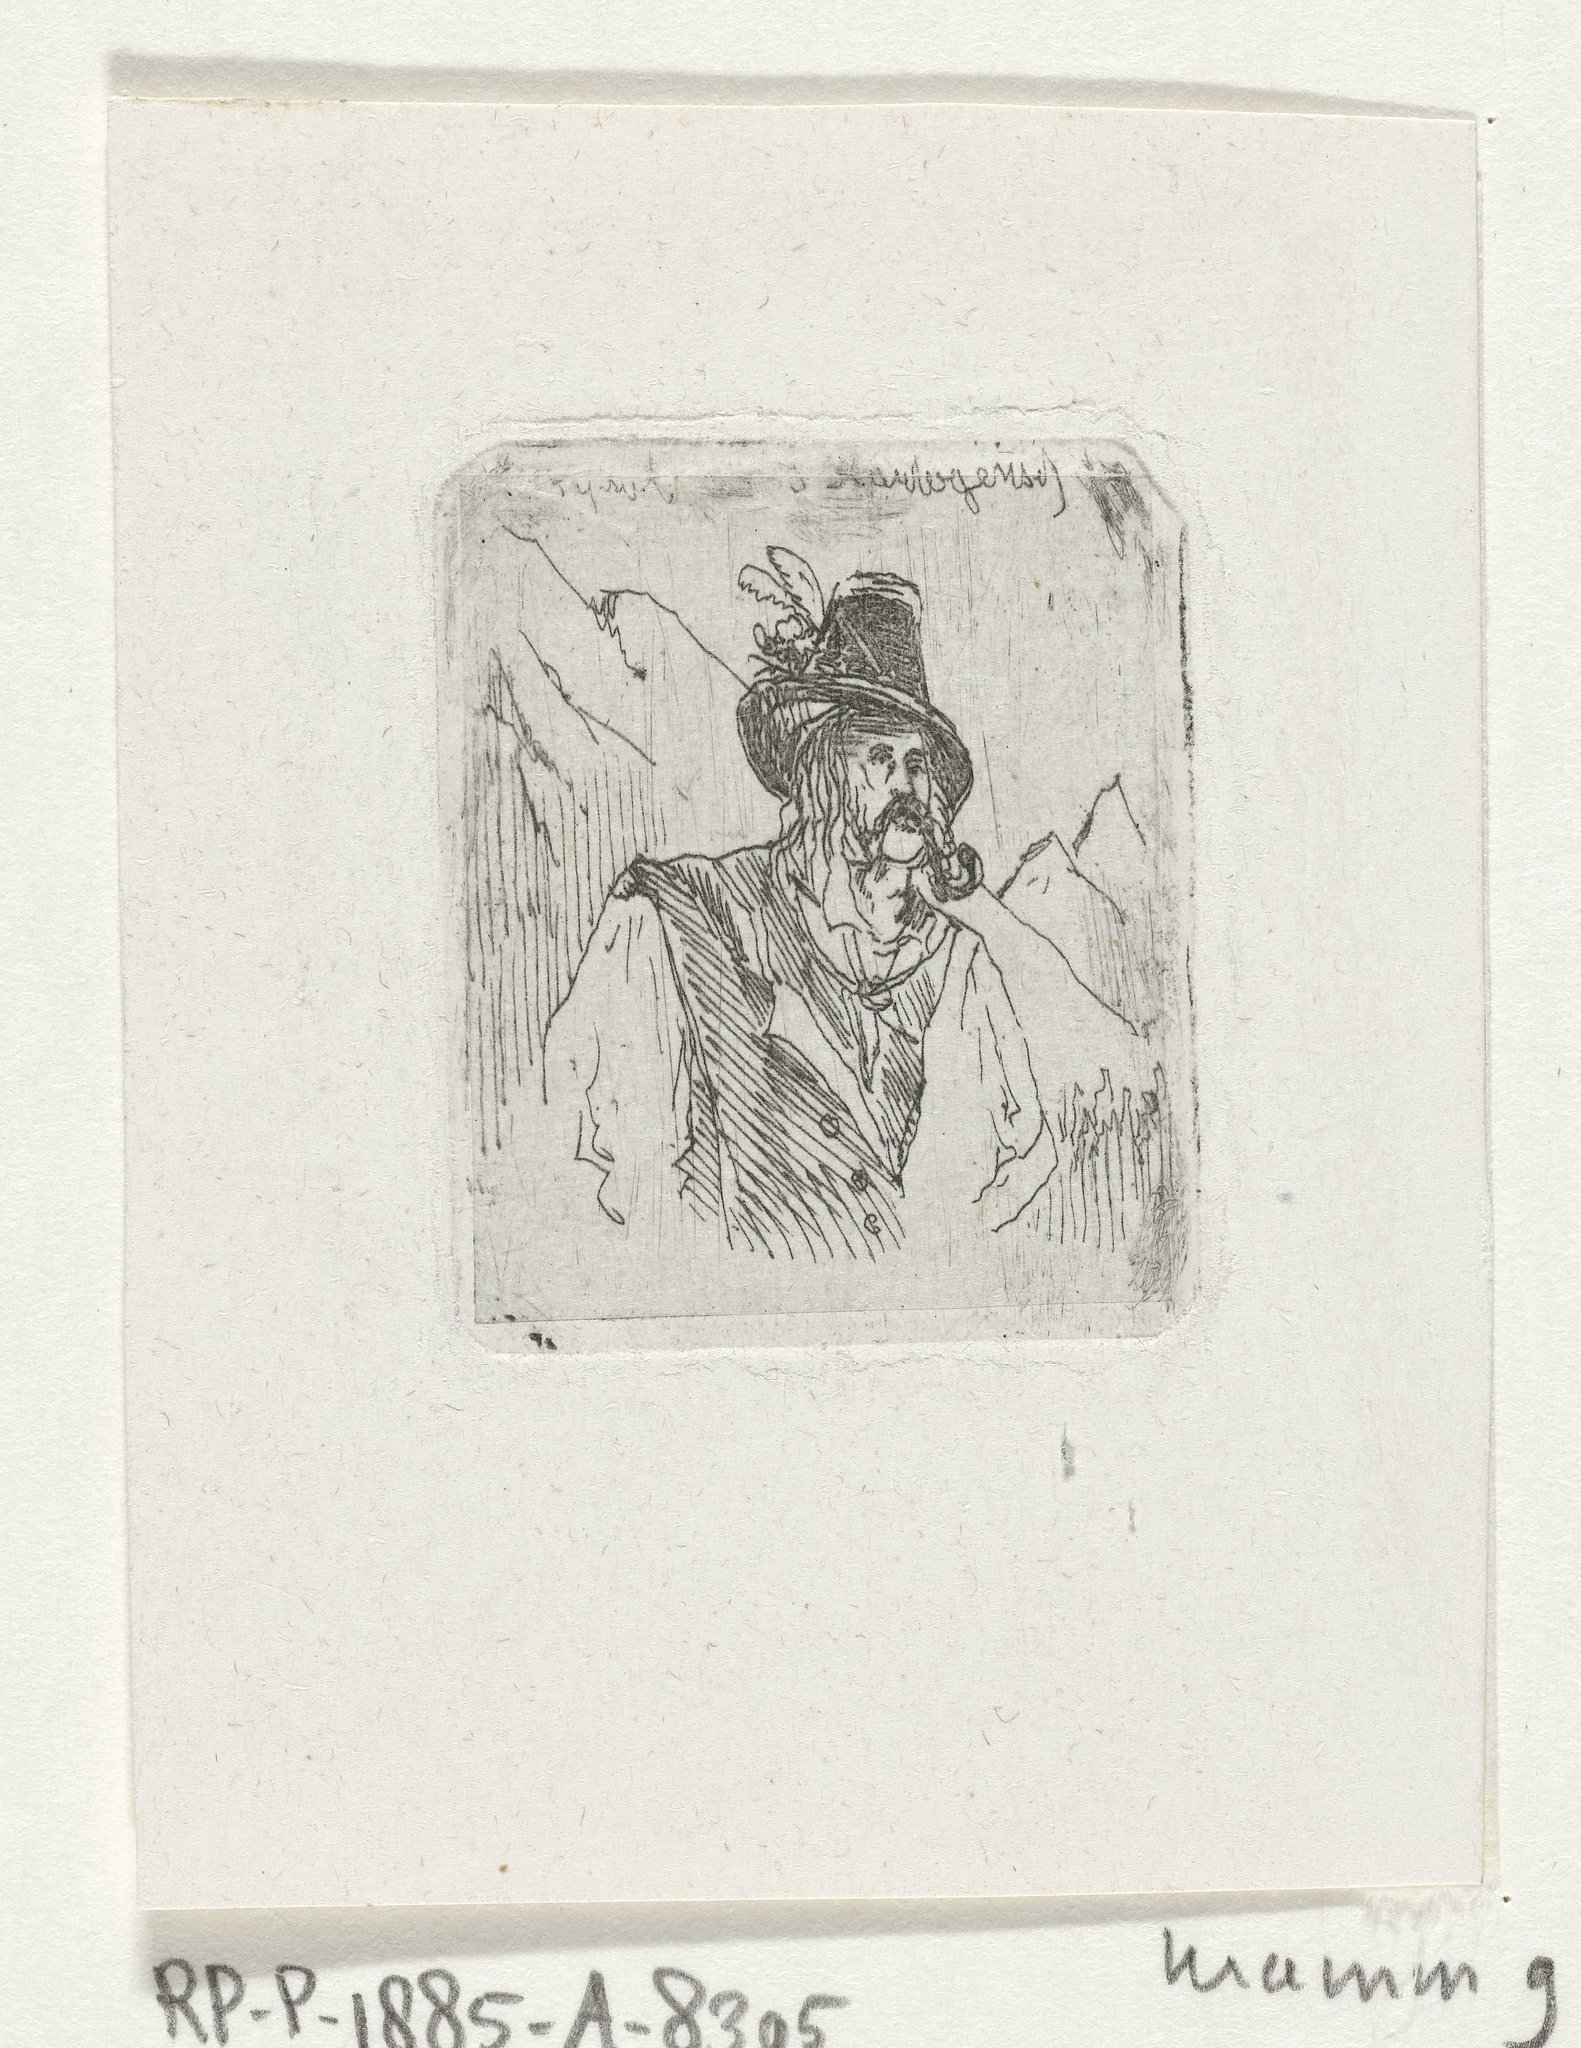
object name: print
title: Tiroler man in een berglandschap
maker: joseph hartogensis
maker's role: painter, print maker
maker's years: 1822-1865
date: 1837-1865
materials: paper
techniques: etching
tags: pipe ~ tobacco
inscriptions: collector's mark: Lugt 2228